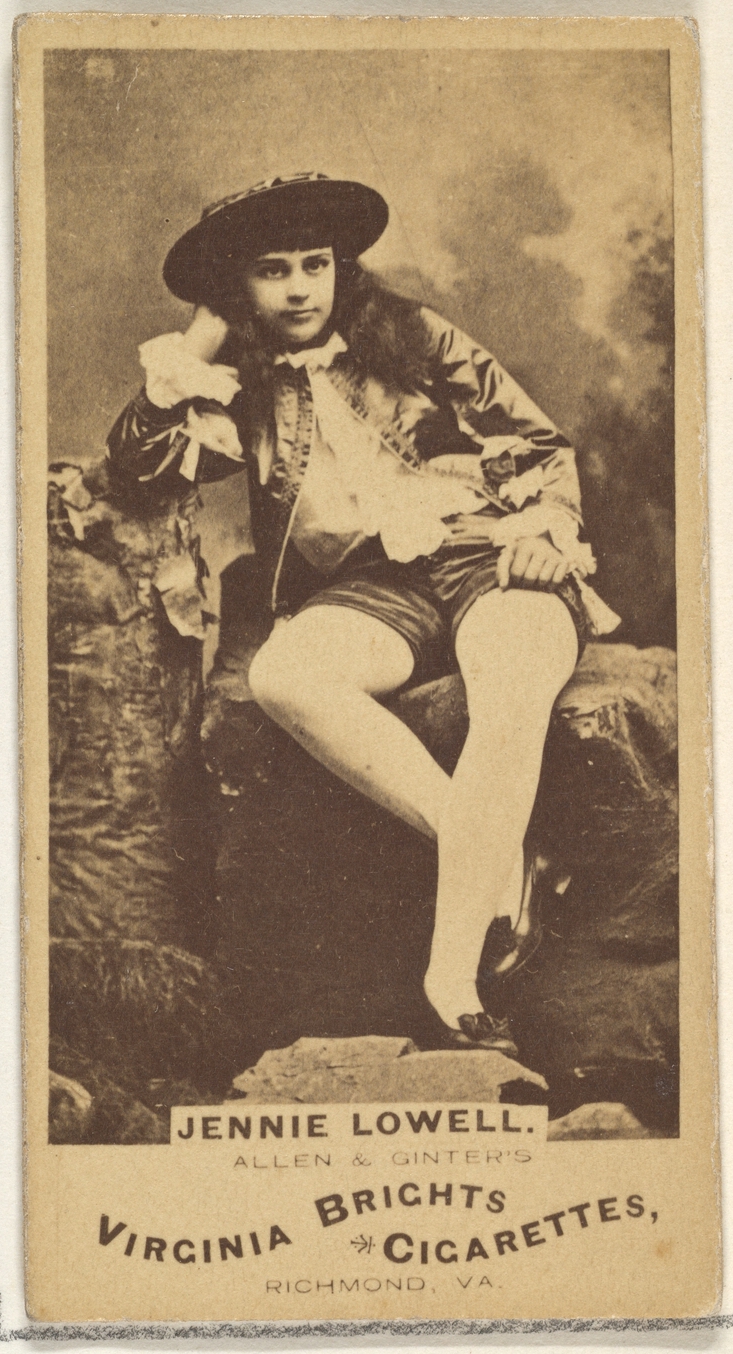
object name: photograph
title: Jennie Lowell, from the Actors and Actresses series (N45, Type 1) for Virginia Brights Cigarettes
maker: allen & ginter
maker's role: publisher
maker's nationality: american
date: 1888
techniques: albumen silver print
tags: portraits,women,actresses